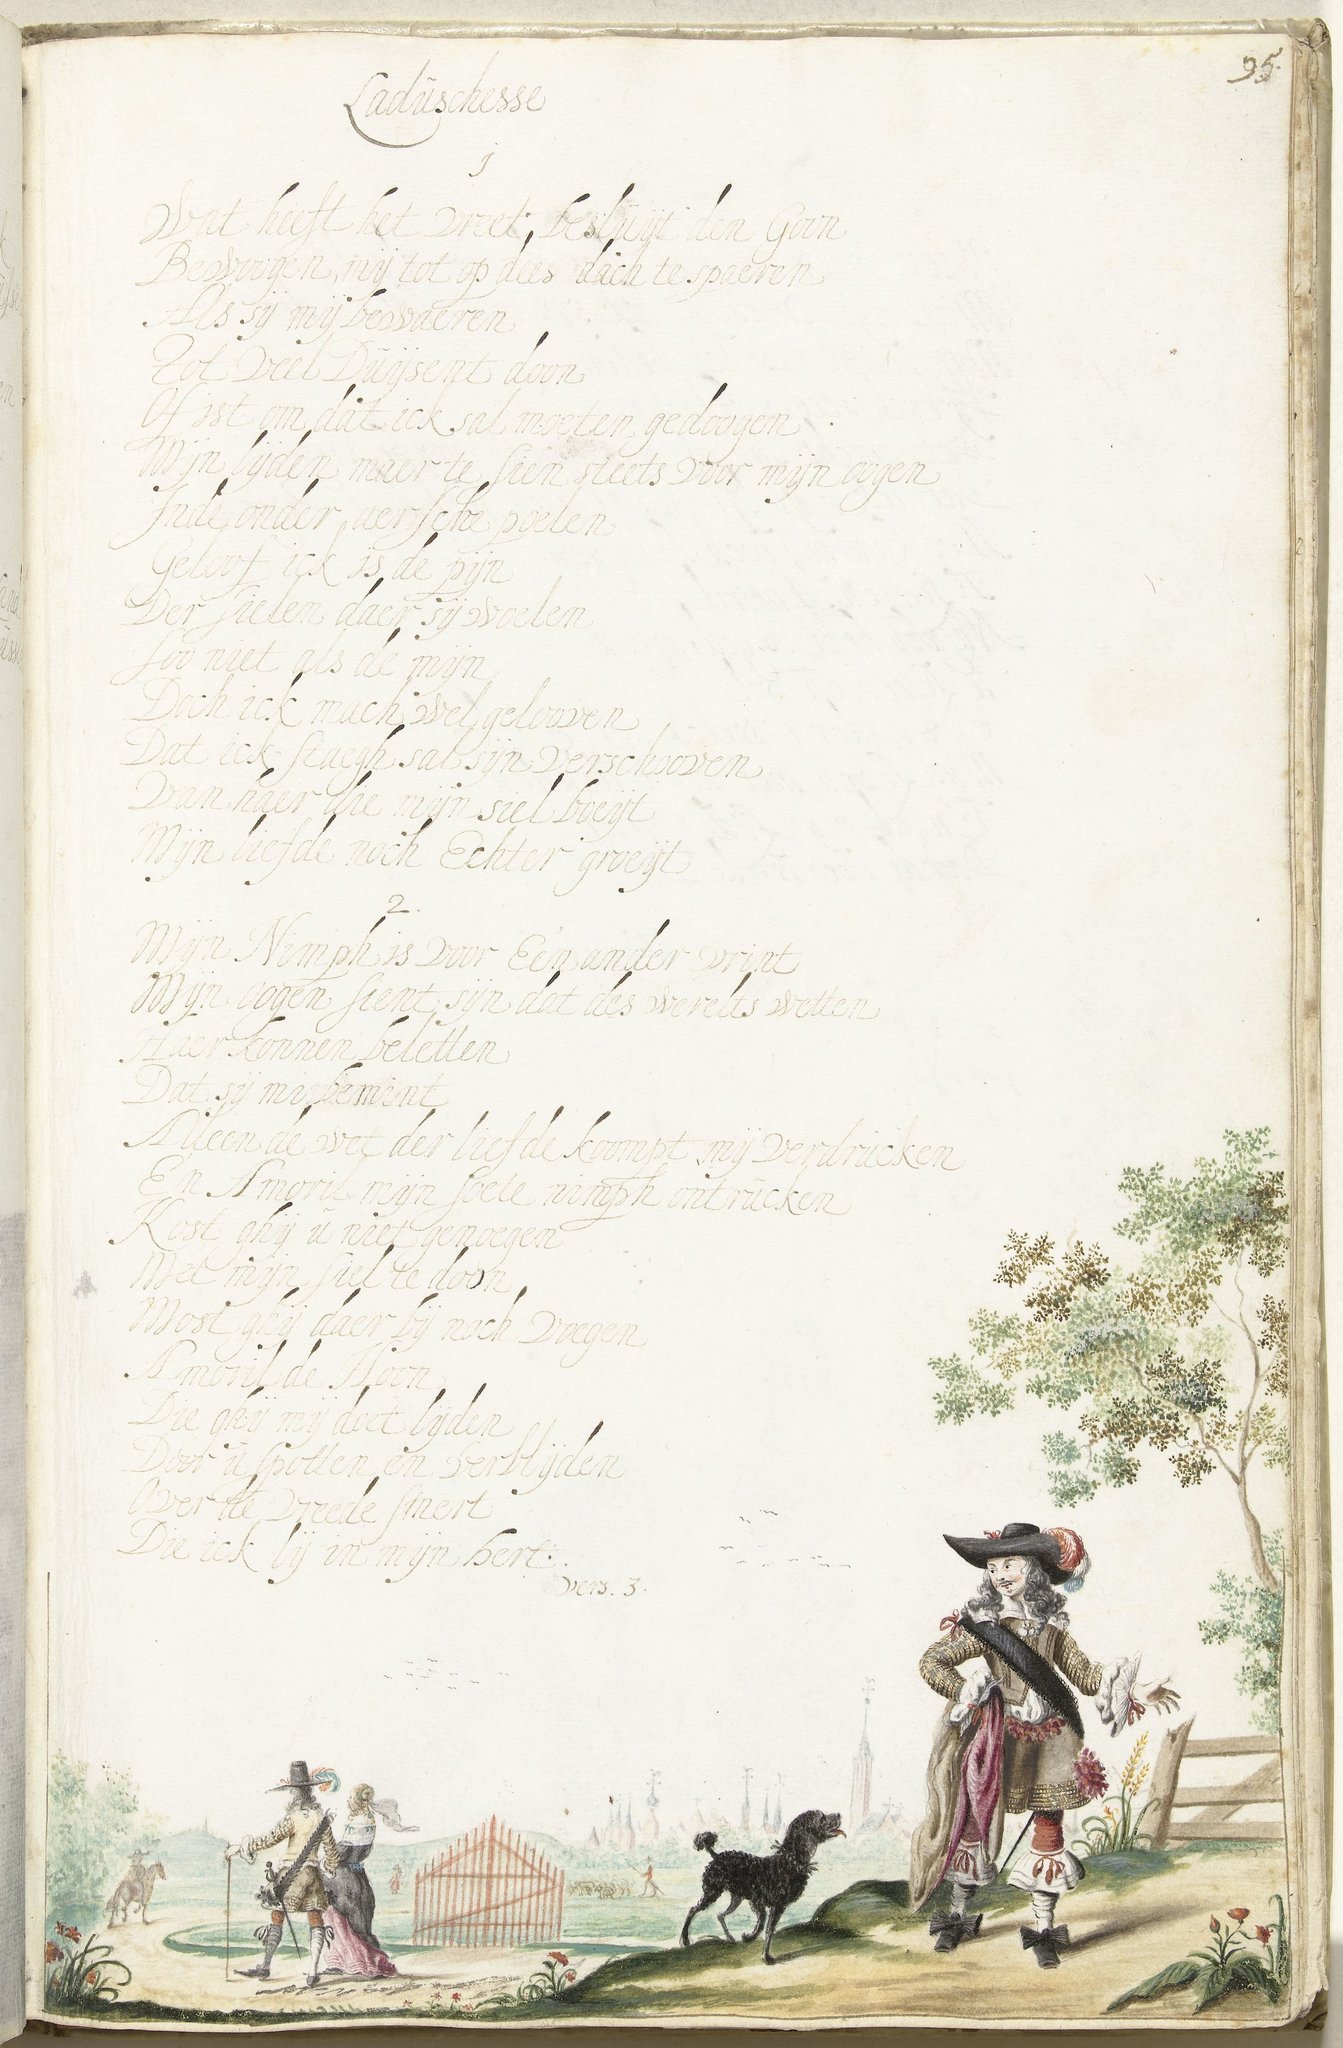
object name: poem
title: Man in een landschap buiten Zwolle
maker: gesina ter borch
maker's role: draughtsman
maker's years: 1633-1690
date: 1659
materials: ink, paper, watercolor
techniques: brush, calligraphy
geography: zwolle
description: Man in een landschap buiten Zwolle naast liefdesklacht over de wrede nimf Amoril op de wijs van Laduschesse.